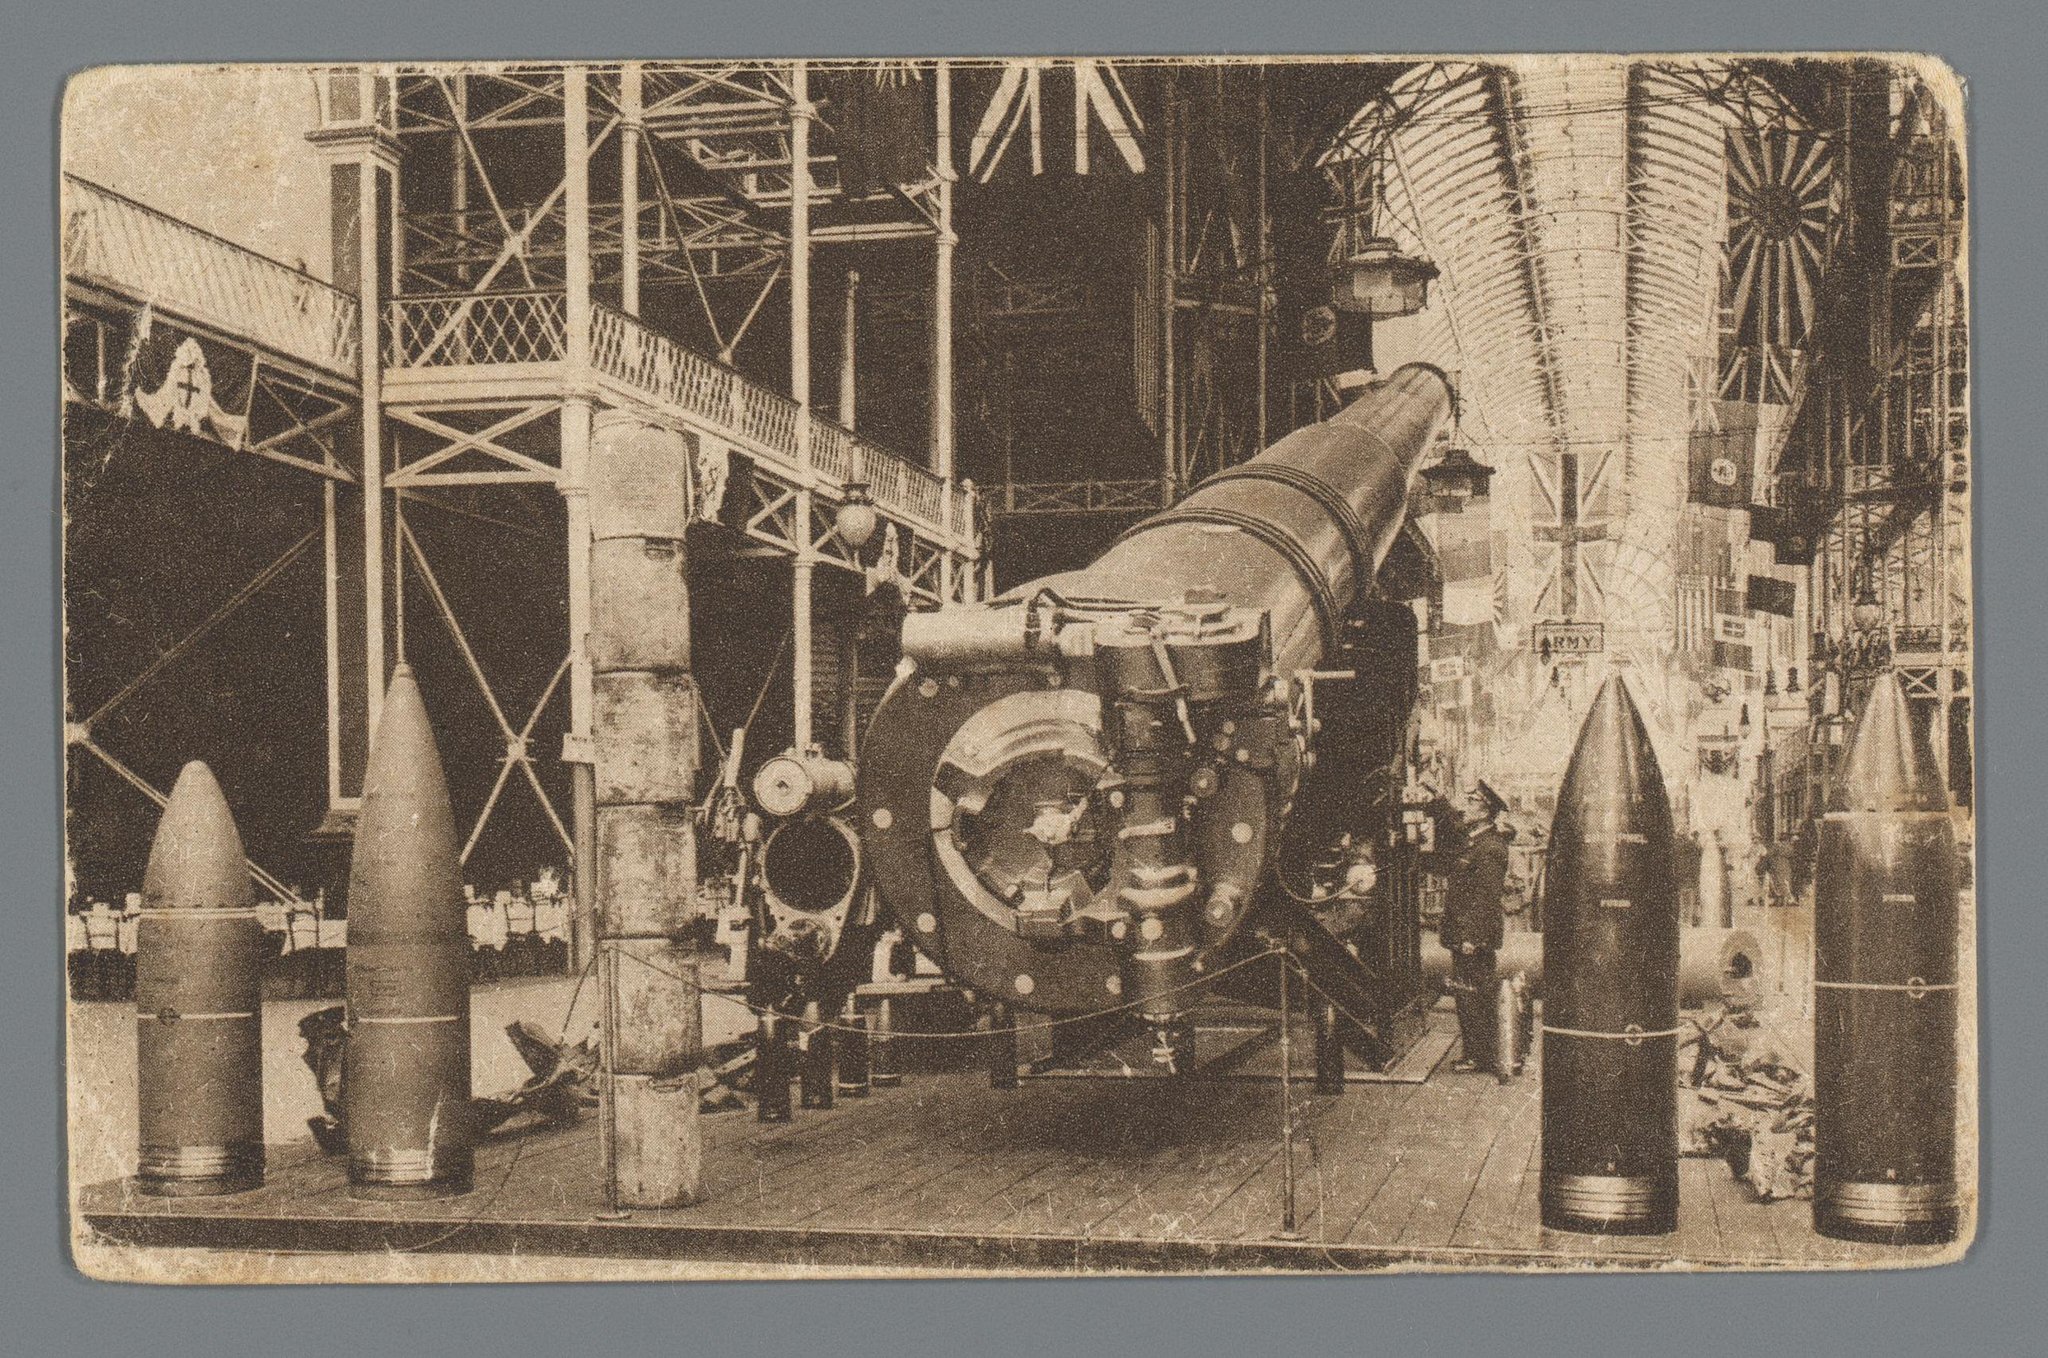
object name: ansichtkaart, prentbriefkaart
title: Replica of 18in. Naval Gun, with Projectiles and Charges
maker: Anonymous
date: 1918-1936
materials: paper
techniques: rotogravure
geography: great britain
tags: weapons, london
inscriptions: inscription: ‘Crown Copyright in letterpress and illustrations reserved.’